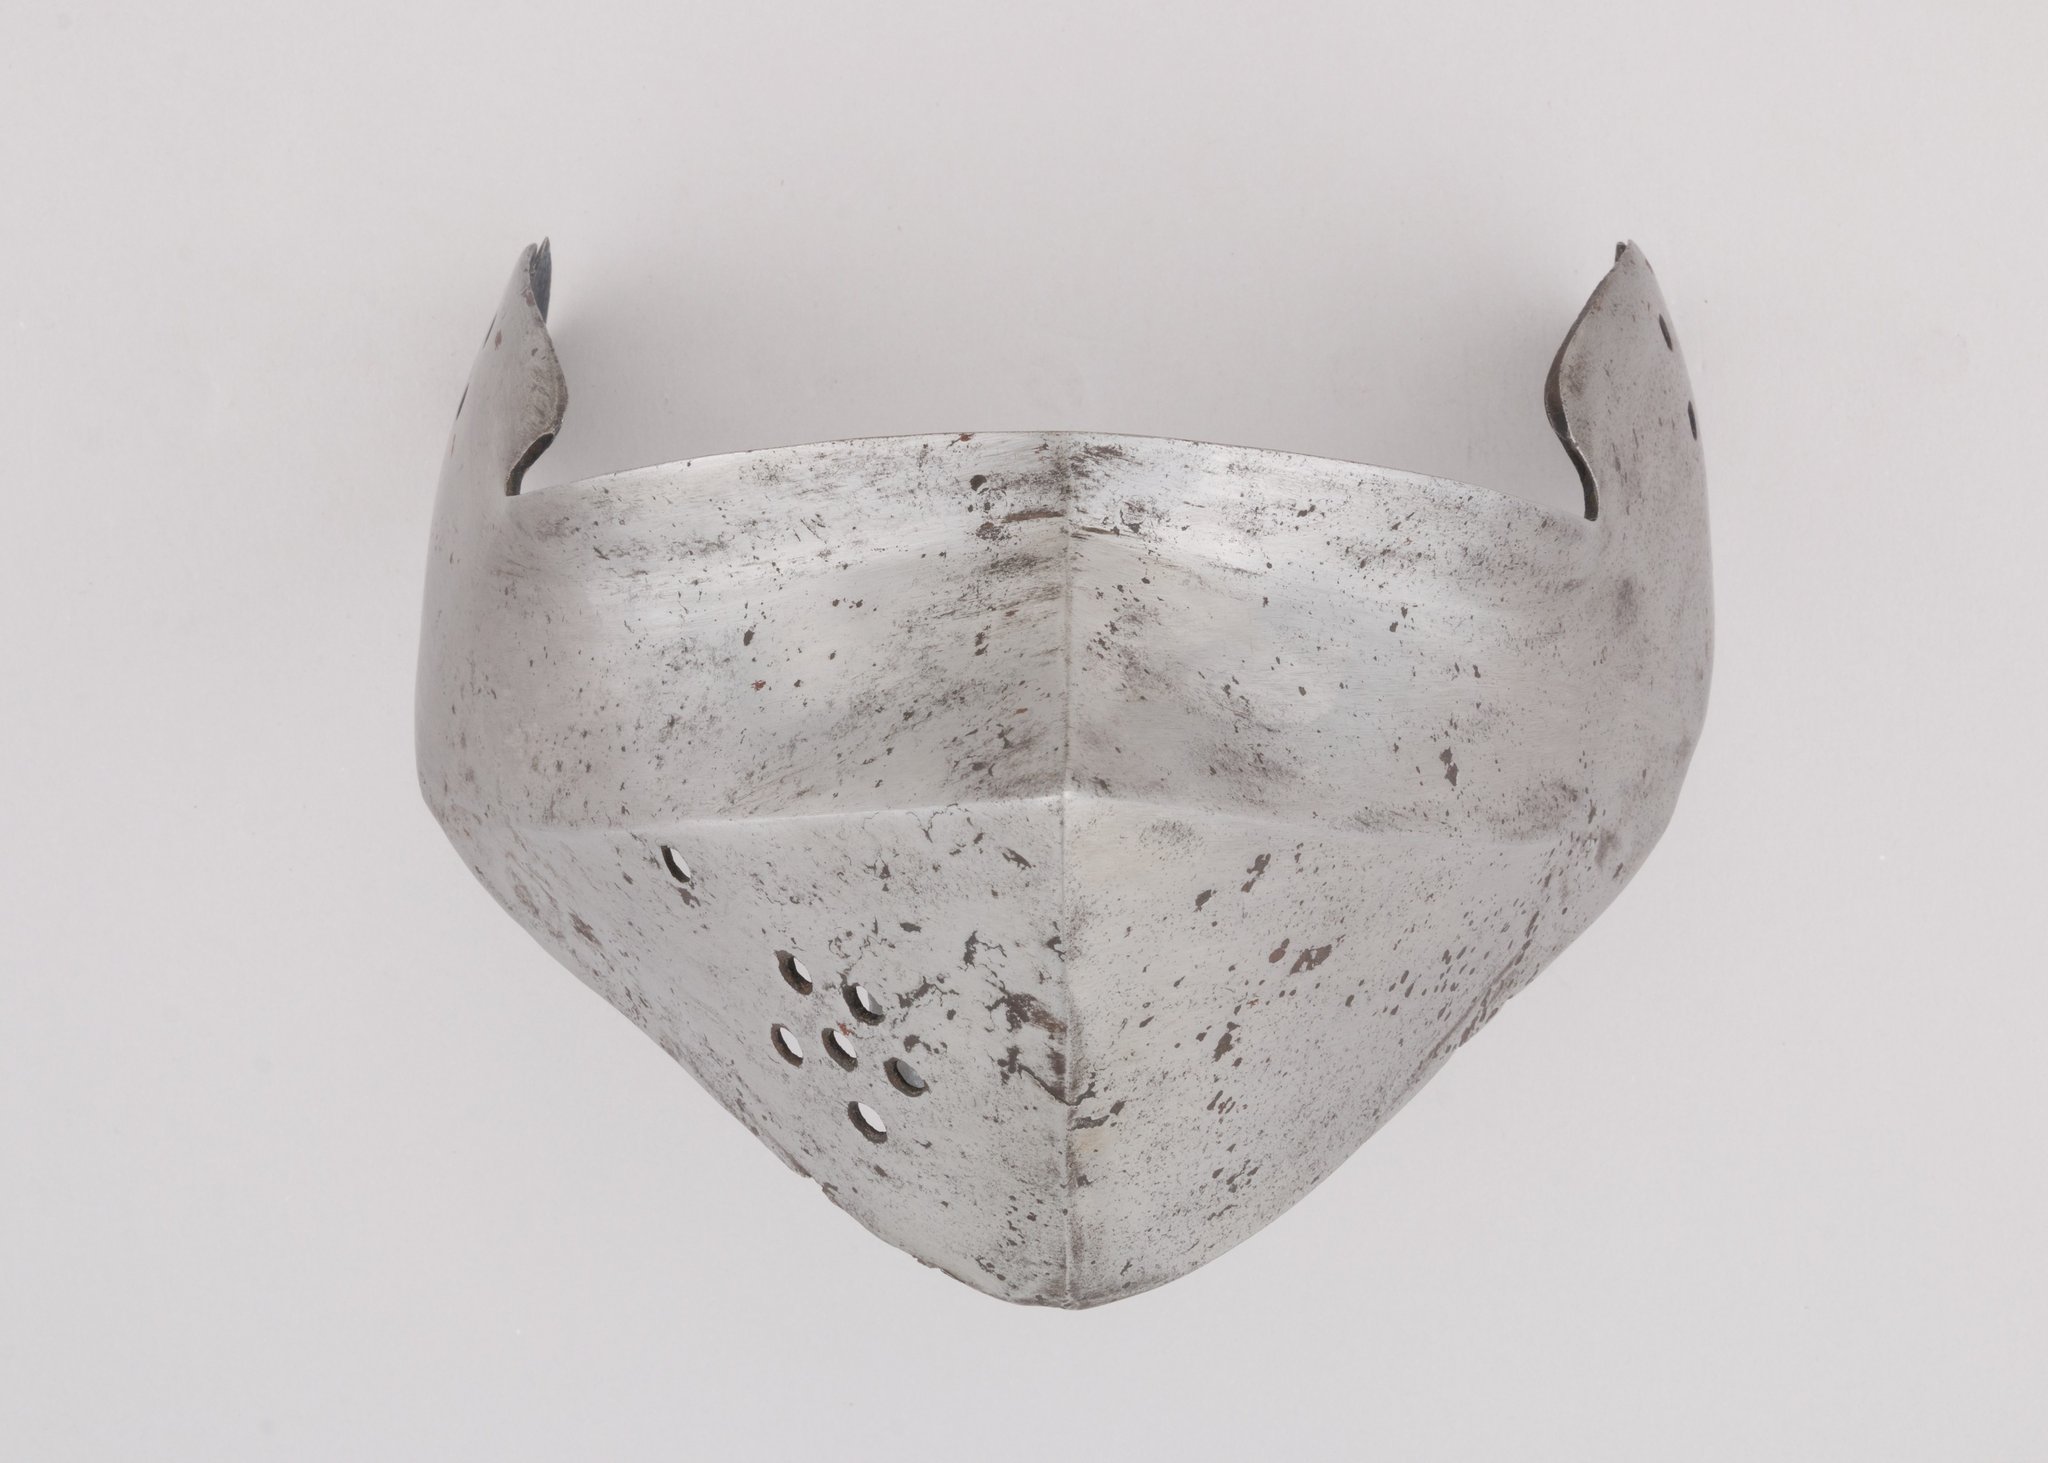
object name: visor for an armet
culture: italian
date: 1475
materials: steel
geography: italy